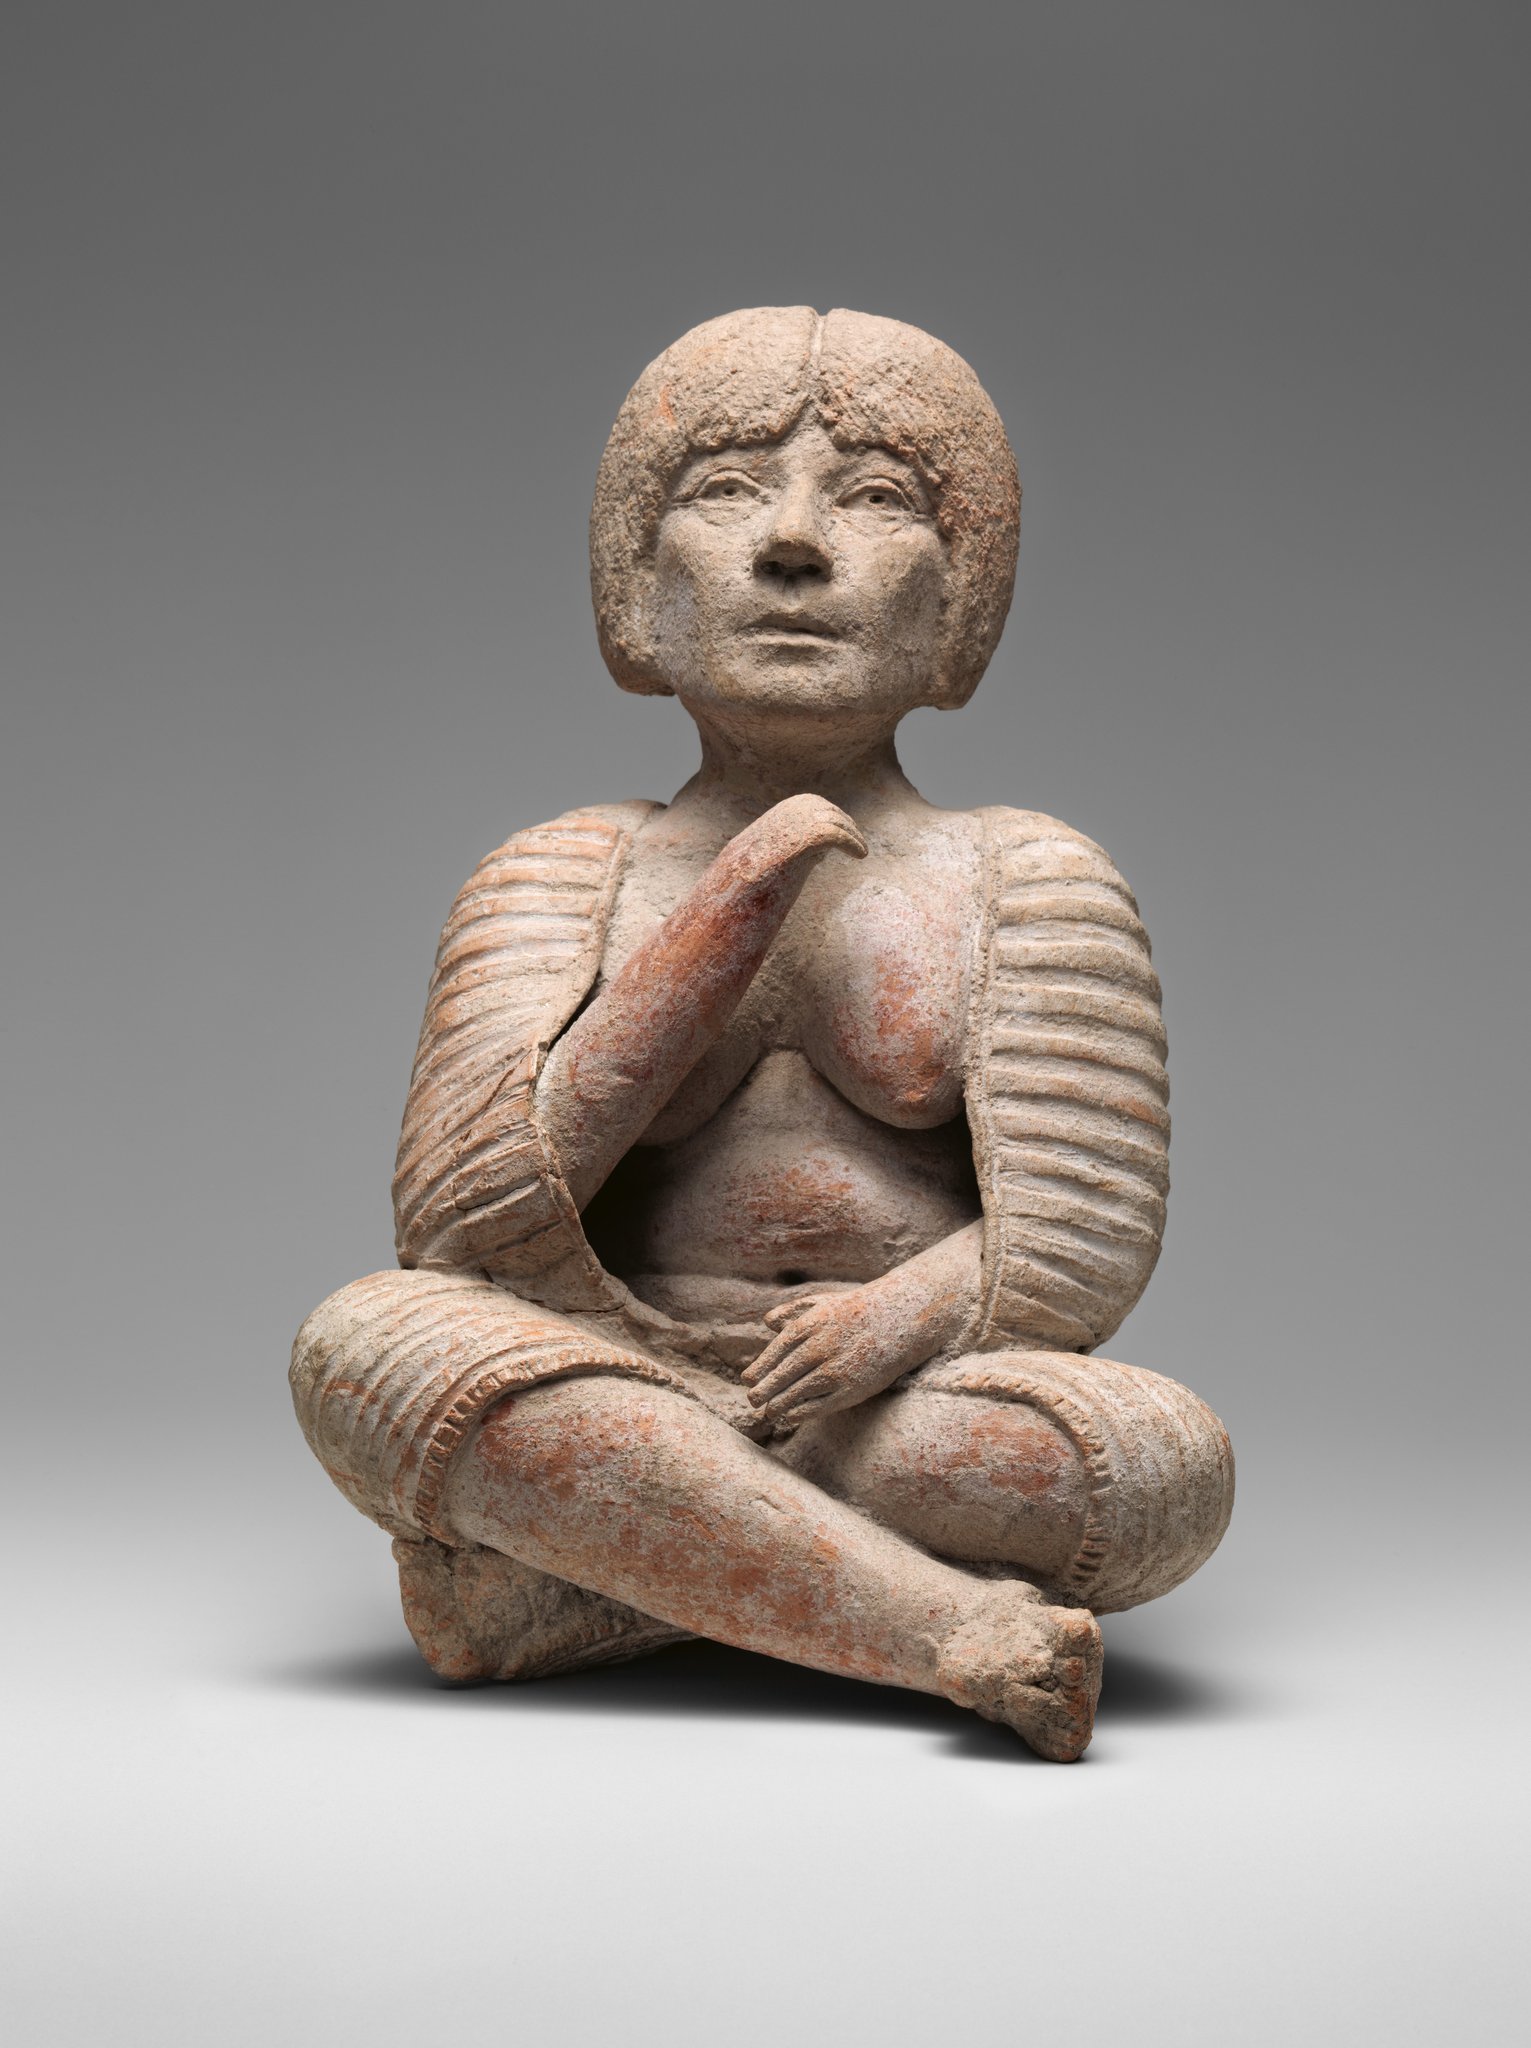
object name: female figure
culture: xochipala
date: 500 BCE-250 CE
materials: ceramic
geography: mexico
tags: women